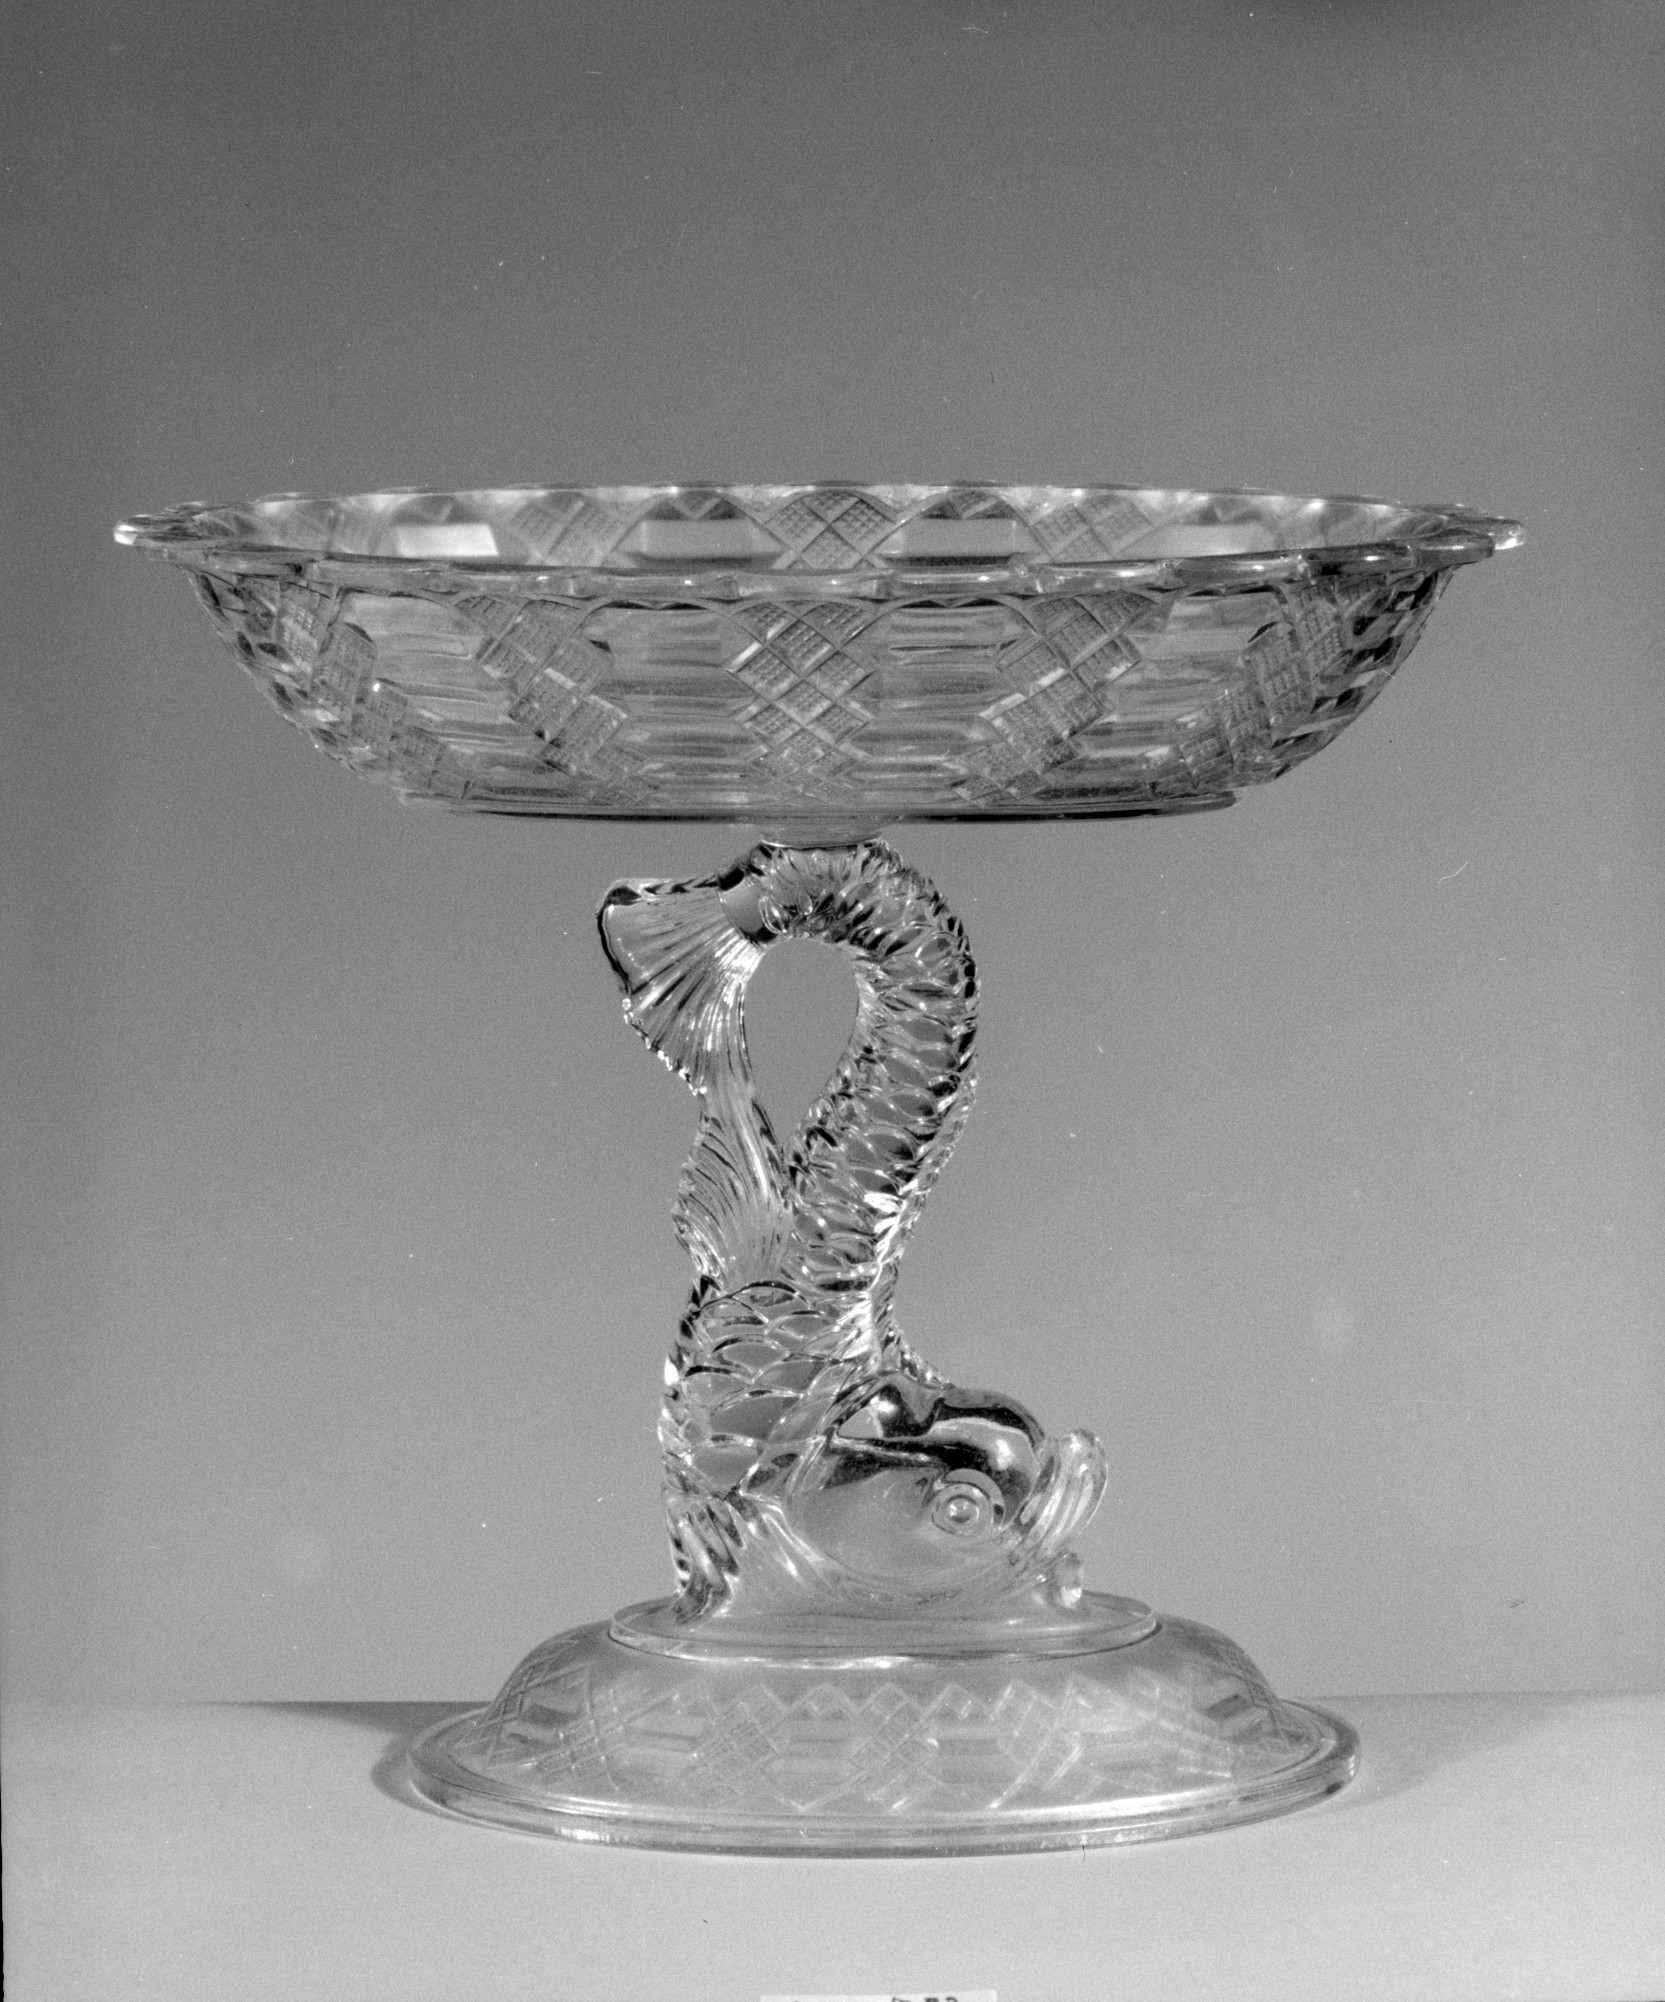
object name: compote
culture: american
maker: bryce brothers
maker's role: maker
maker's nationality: american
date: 1876-1885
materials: glass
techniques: pressed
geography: united states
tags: dolphins